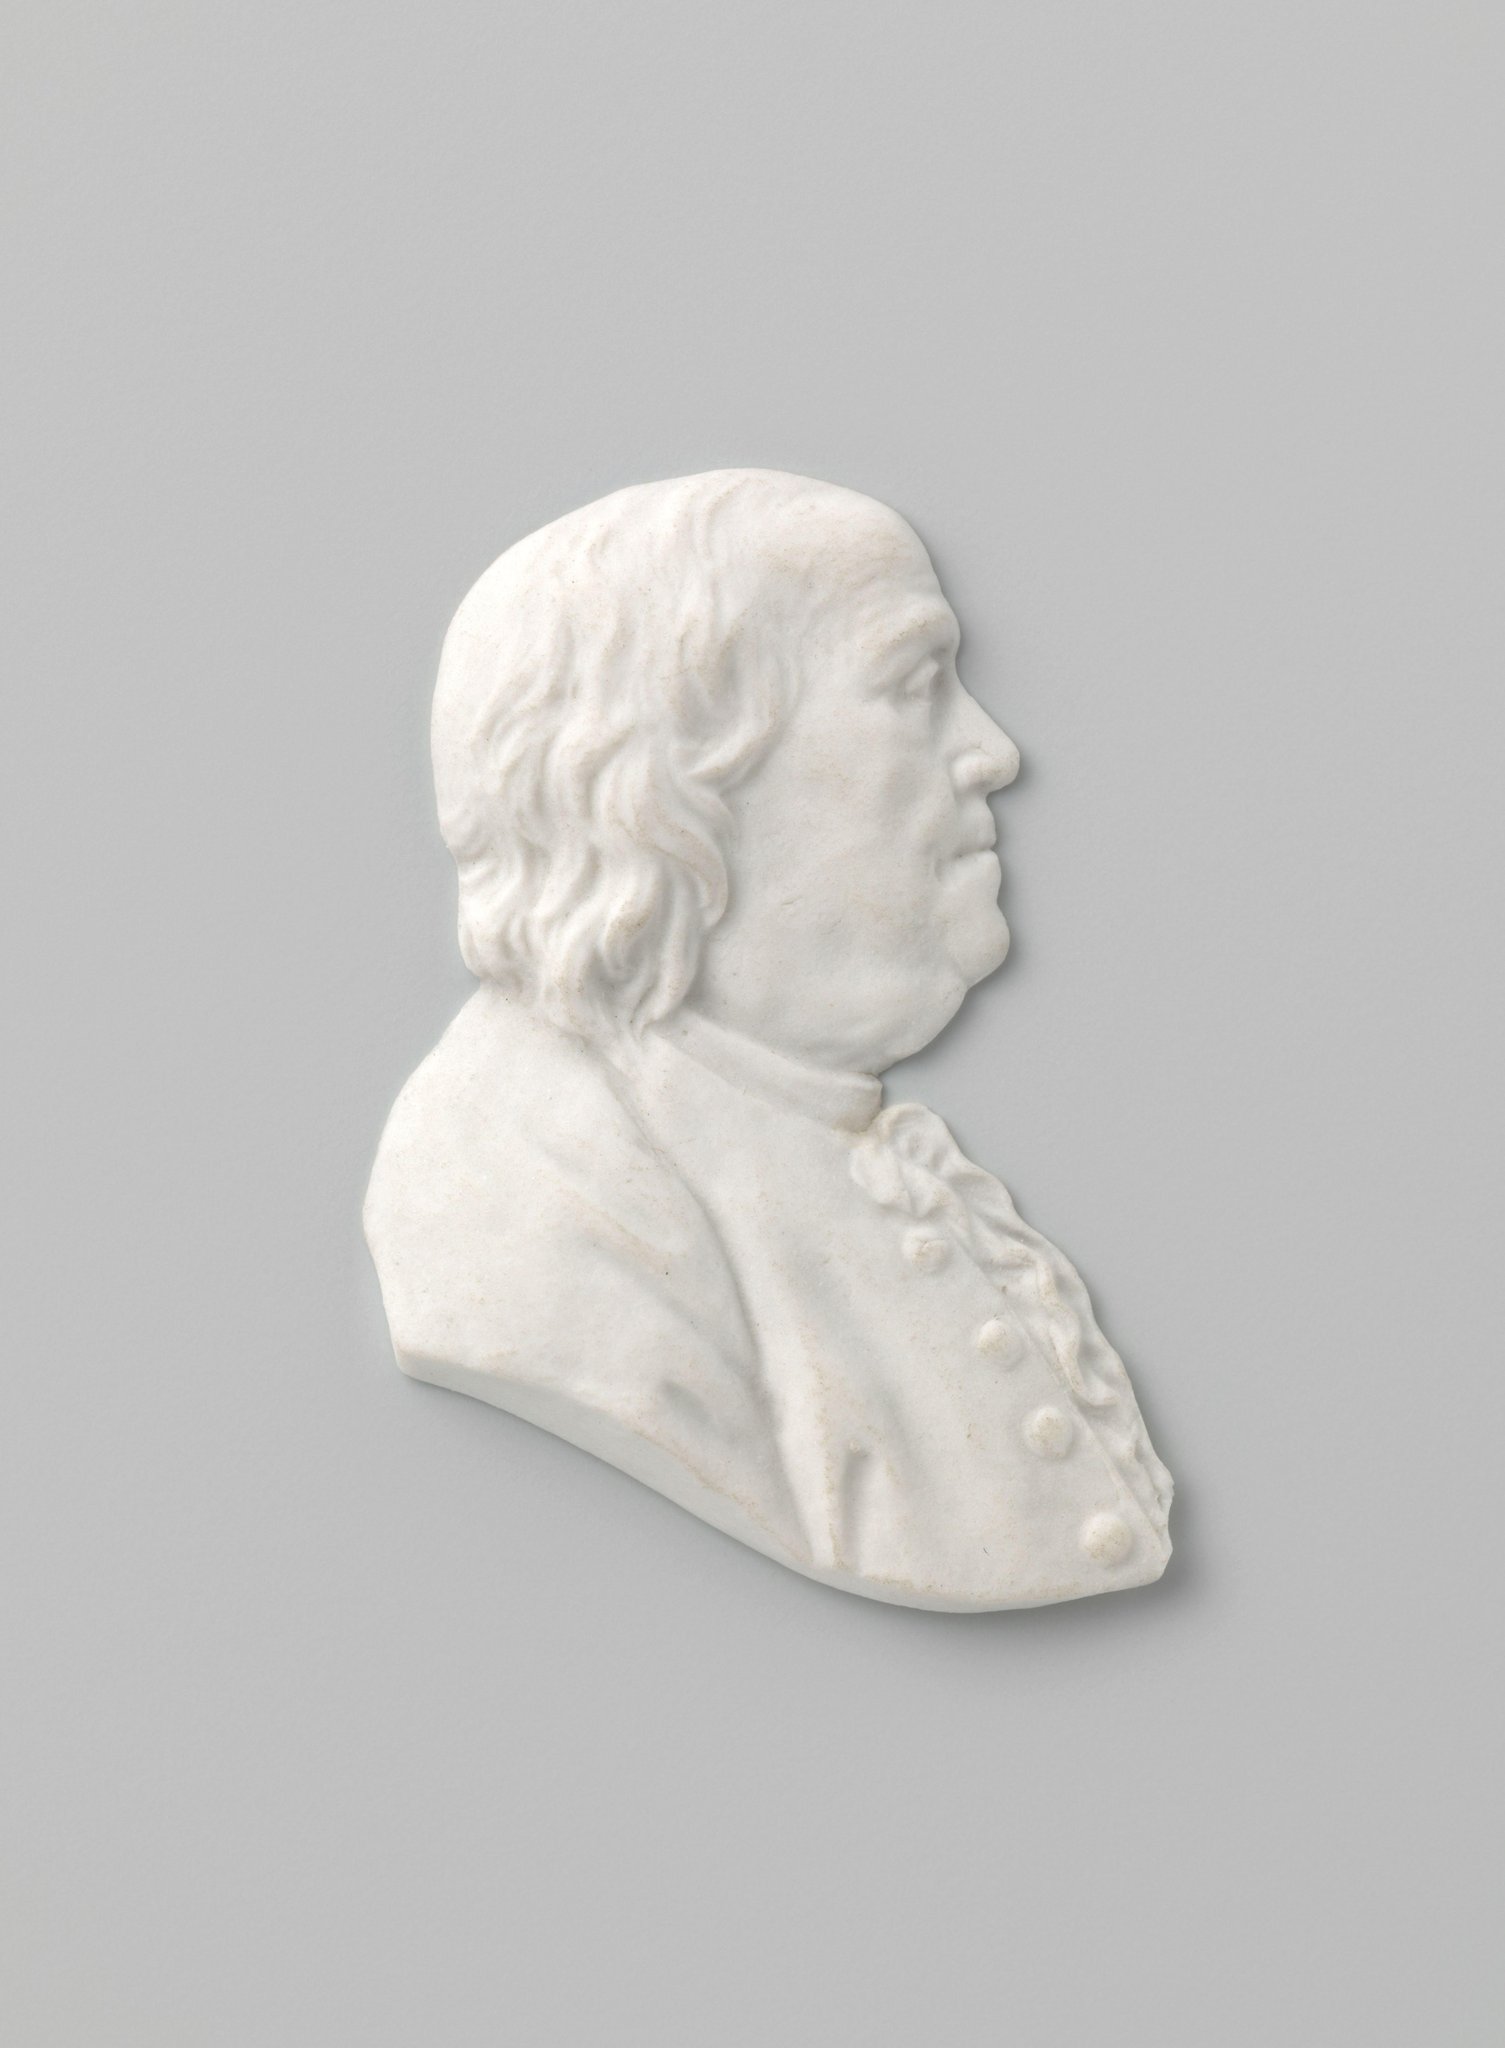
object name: relief sculpture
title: Portrait of Benjamin Franklin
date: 1780-1795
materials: porcelain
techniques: forming, relief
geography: sèvres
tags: physicist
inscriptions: inscription: ‘B:FRANKLIN’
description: Five portraits, from left to right: Benjamin Franklin, the Marquis de La Fayette, the Comte de Mirabeau, Jean-Jacques Rousseau and Marie Antoinette. Biscuit porcelain. Sèvres, c. 1780 - 1795. On loan from the Koninklijk Oudheidkundig Genootschap.